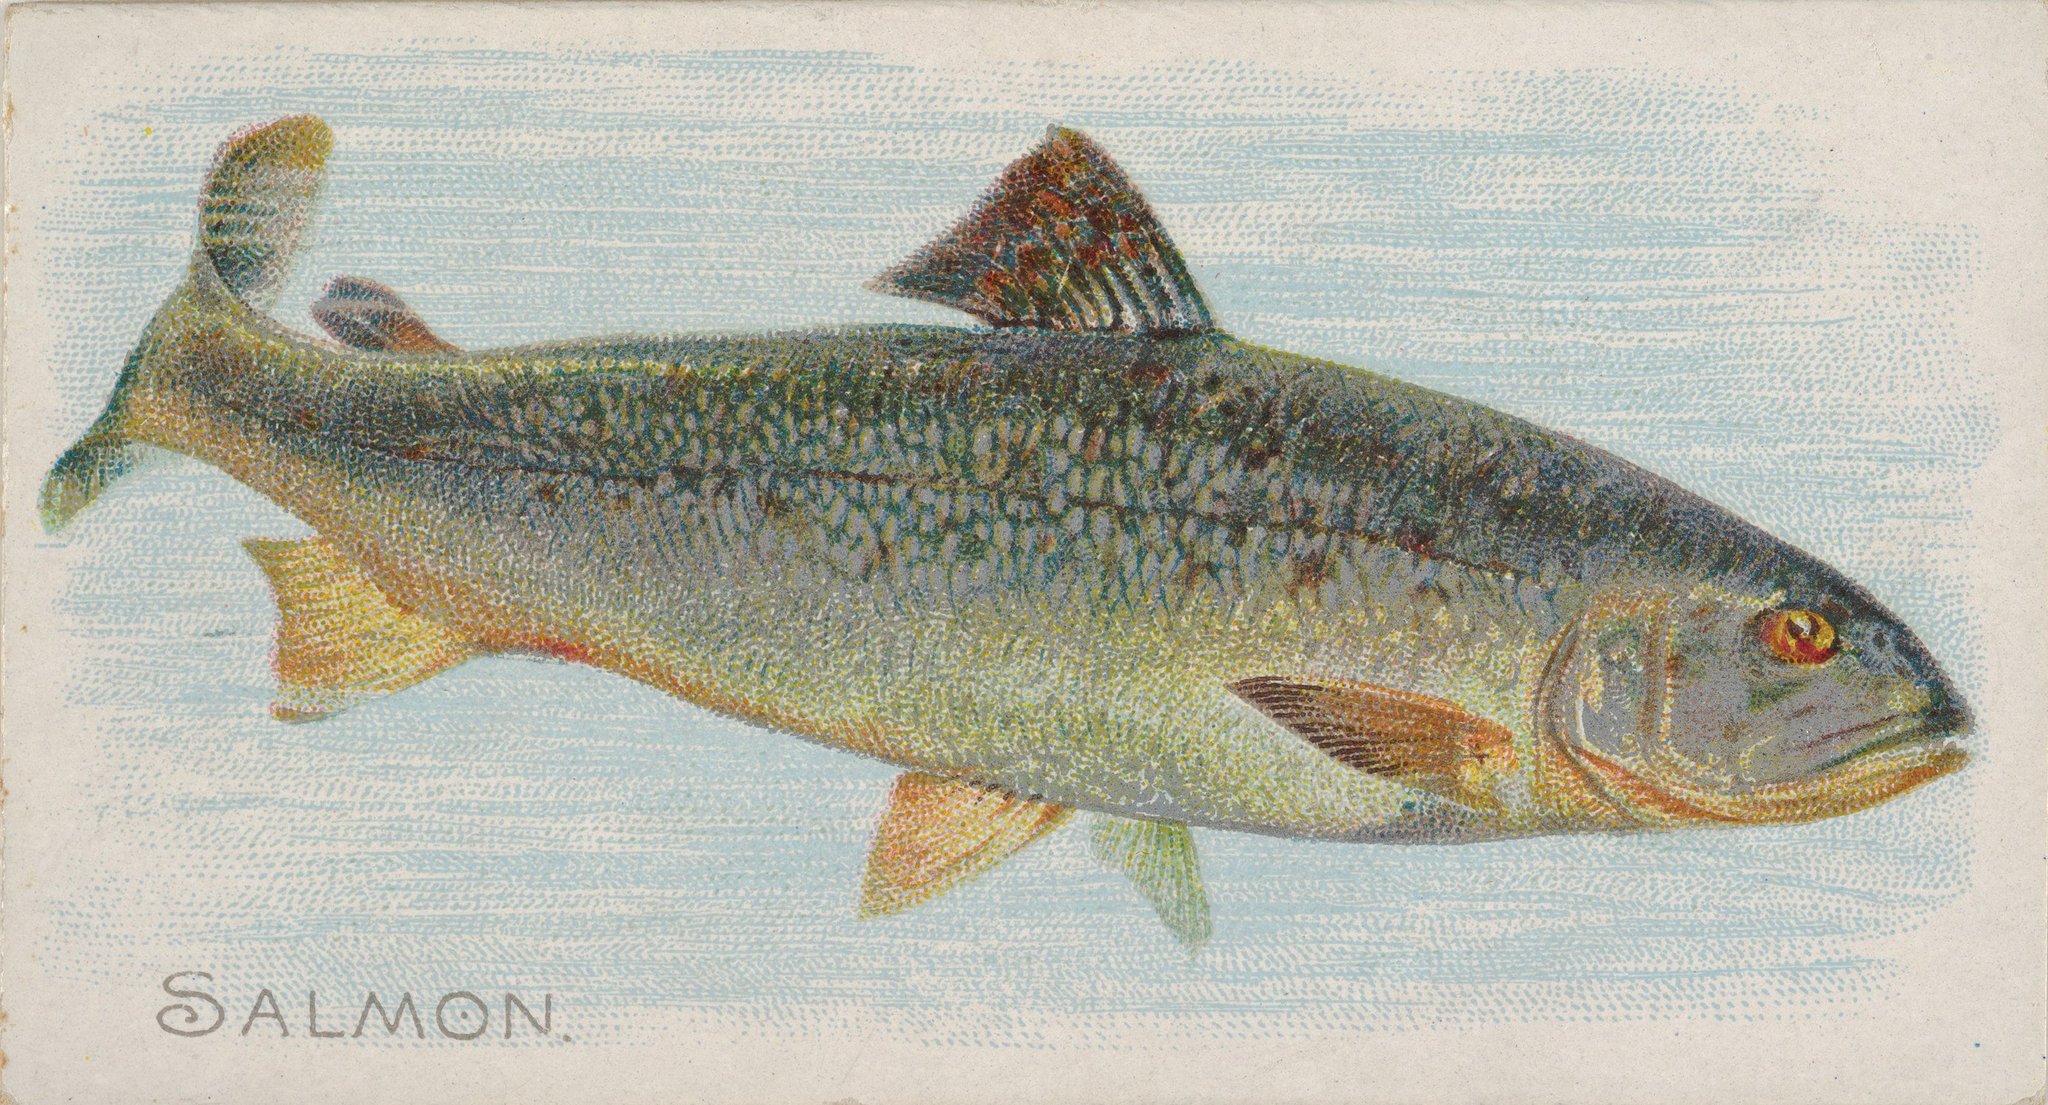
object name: print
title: Salmon, from the Fish from American Waters series (N8) for Allen & Ginter Cigarettes Brands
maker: allen & ginter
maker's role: publisher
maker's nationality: american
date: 1889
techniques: color lithograph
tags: fish